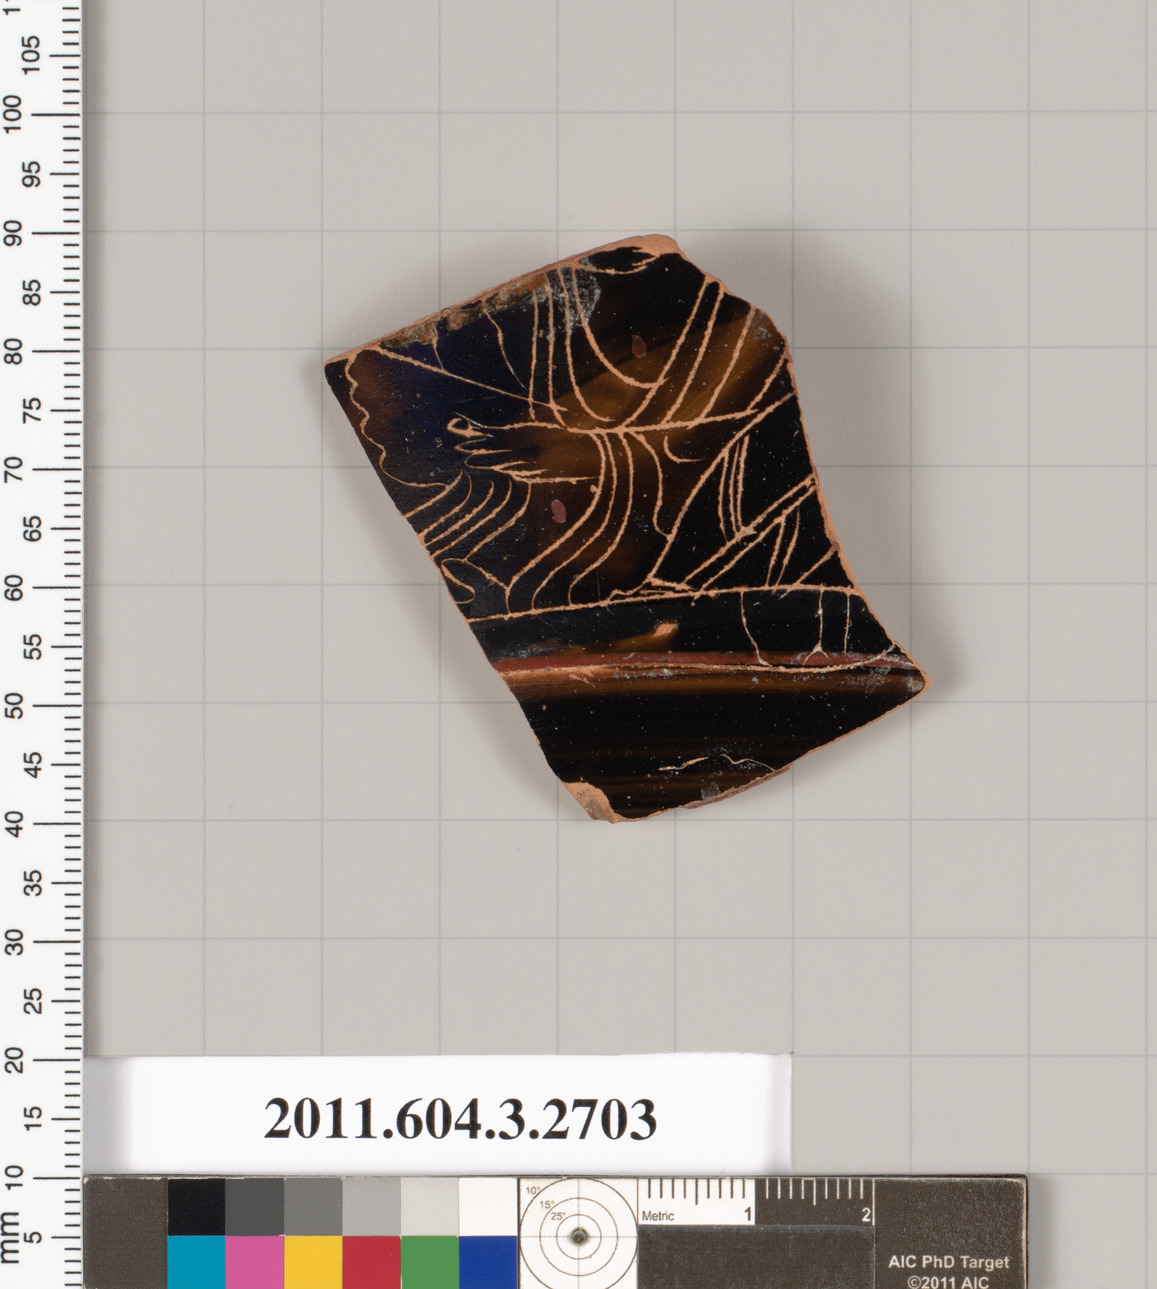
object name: oinochoe fragment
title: Terracotta fragment of an oinochoe (jug)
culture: greek, attic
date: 534-468 BCE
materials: terracotta